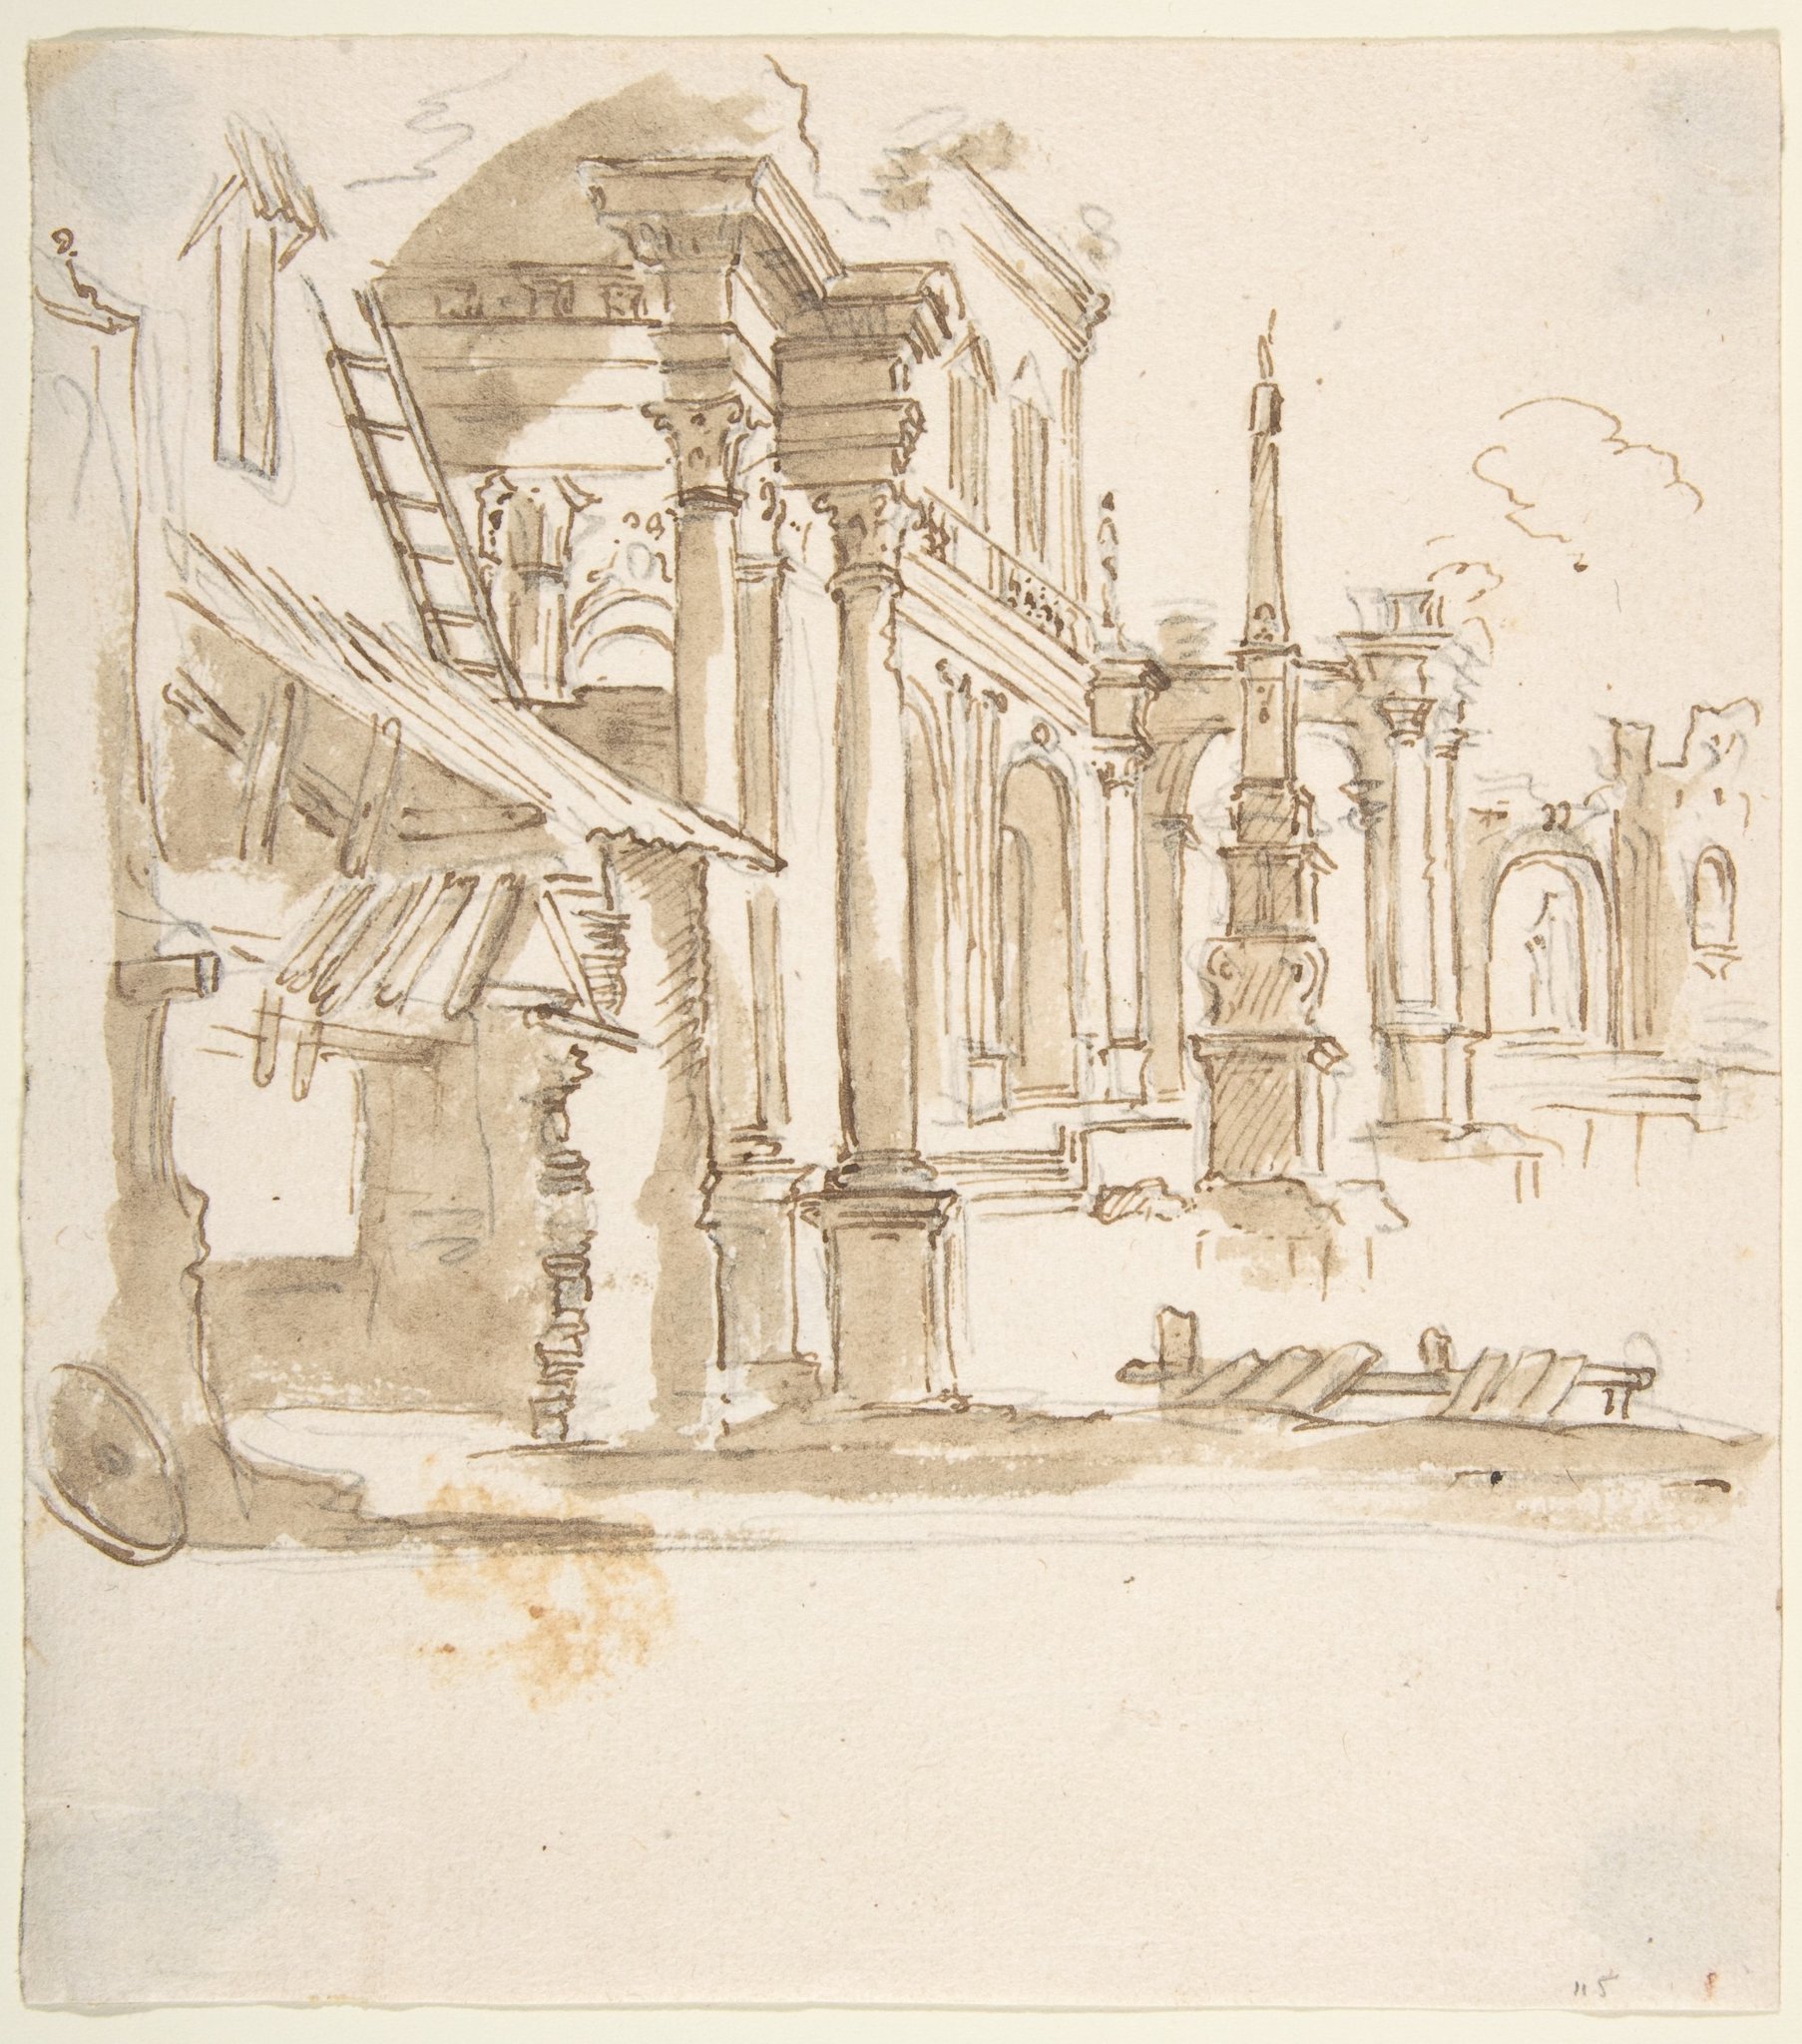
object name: drawing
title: Capriccio with Architectural Ruins in Perspective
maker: anonymous, italian, piedmontese, 18th century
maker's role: artist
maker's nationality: italian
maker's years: 1700-1800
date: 1700-1780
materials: graphite, ink, drawing material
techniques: brush, pen, wash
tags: buildings,ruins